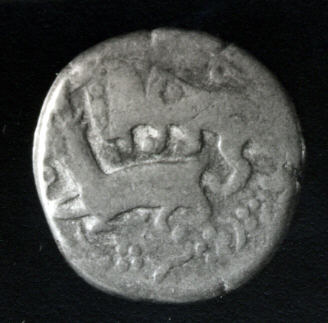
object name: coin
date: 1101-1300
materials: copper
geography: iran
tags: animals